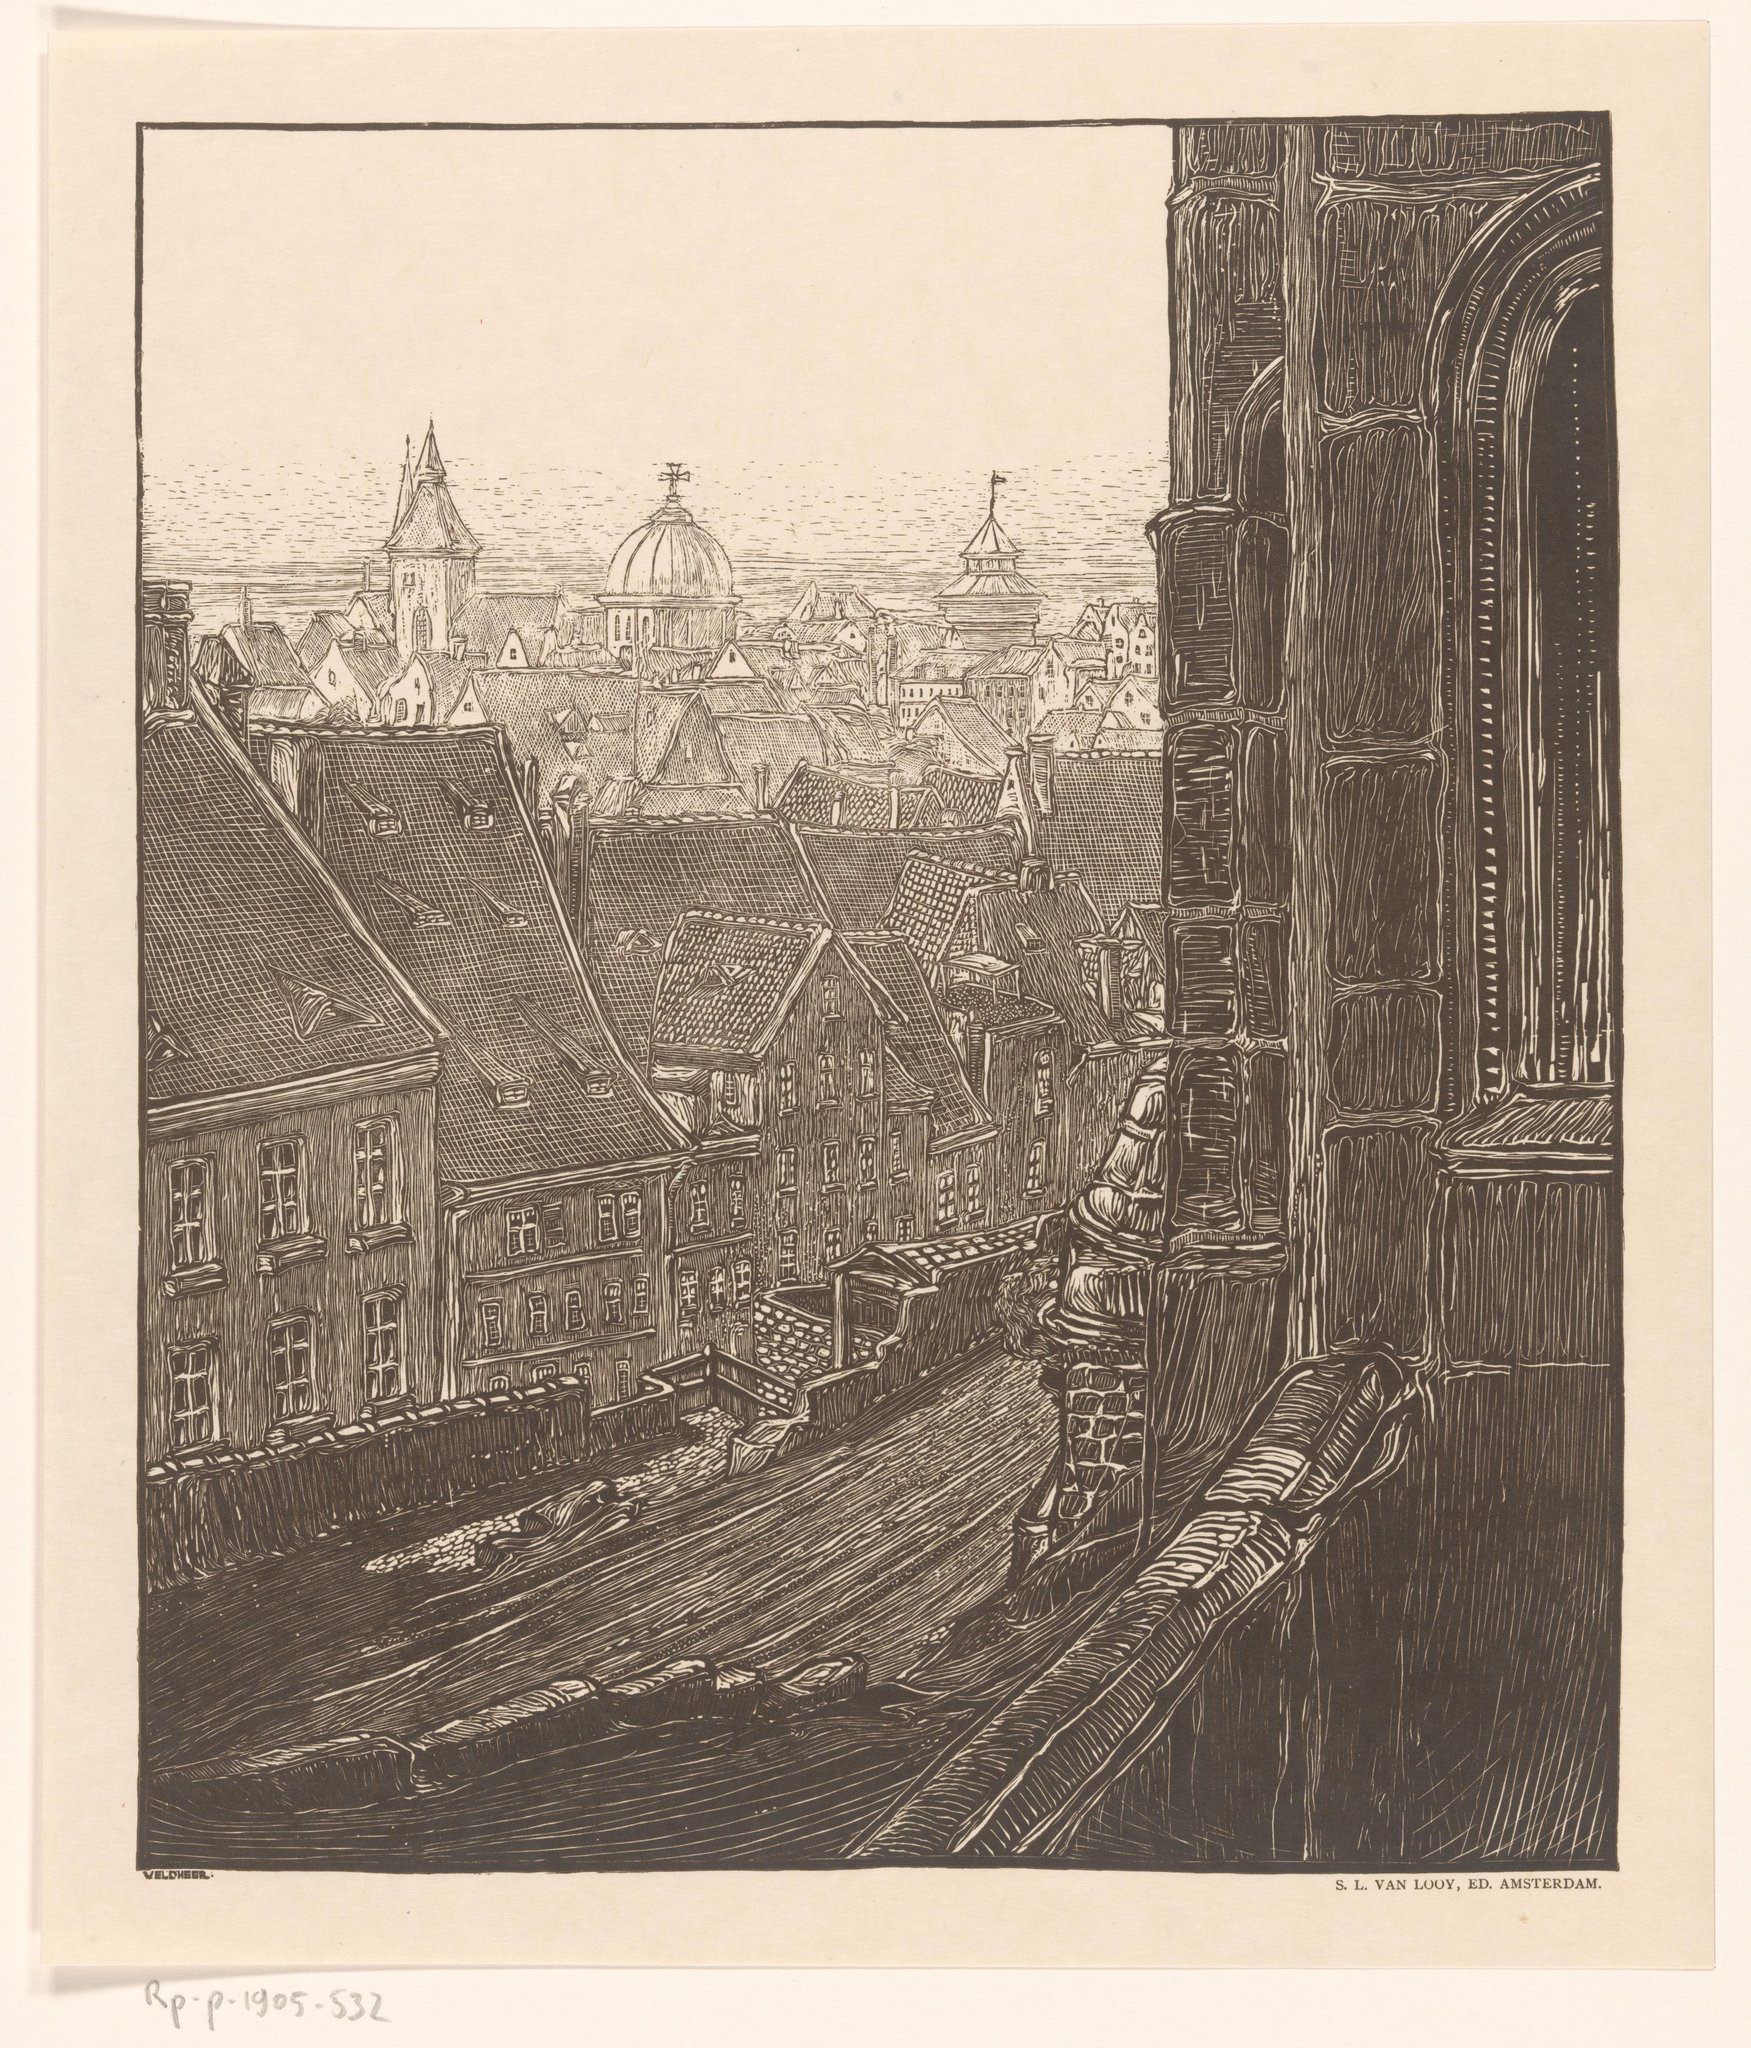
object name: print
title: Stadsgezicht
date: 1886-1905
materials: paper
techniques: woodcut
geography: amsterdam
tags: city-view in general; 'veduta'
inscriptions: collector's mark: Lugt 2228